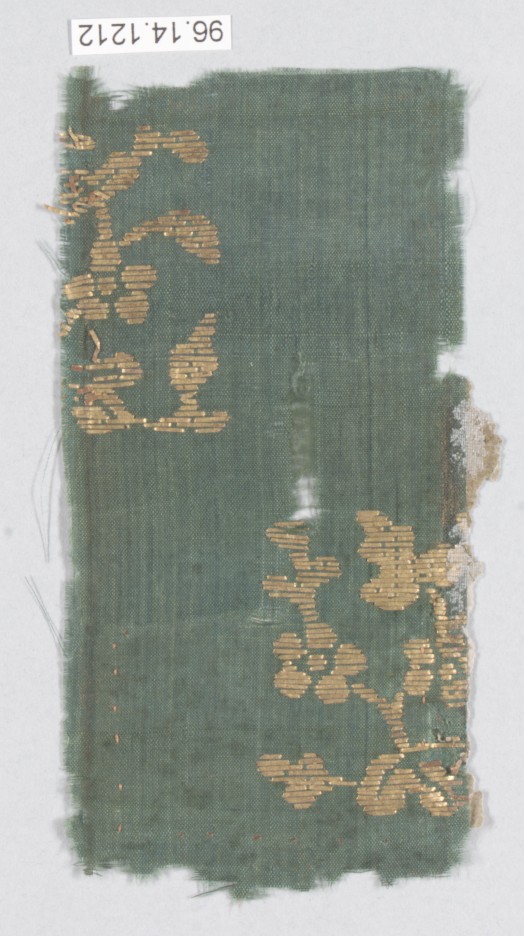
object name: piece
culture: japanese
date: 1801-1833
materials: metal thread, silk